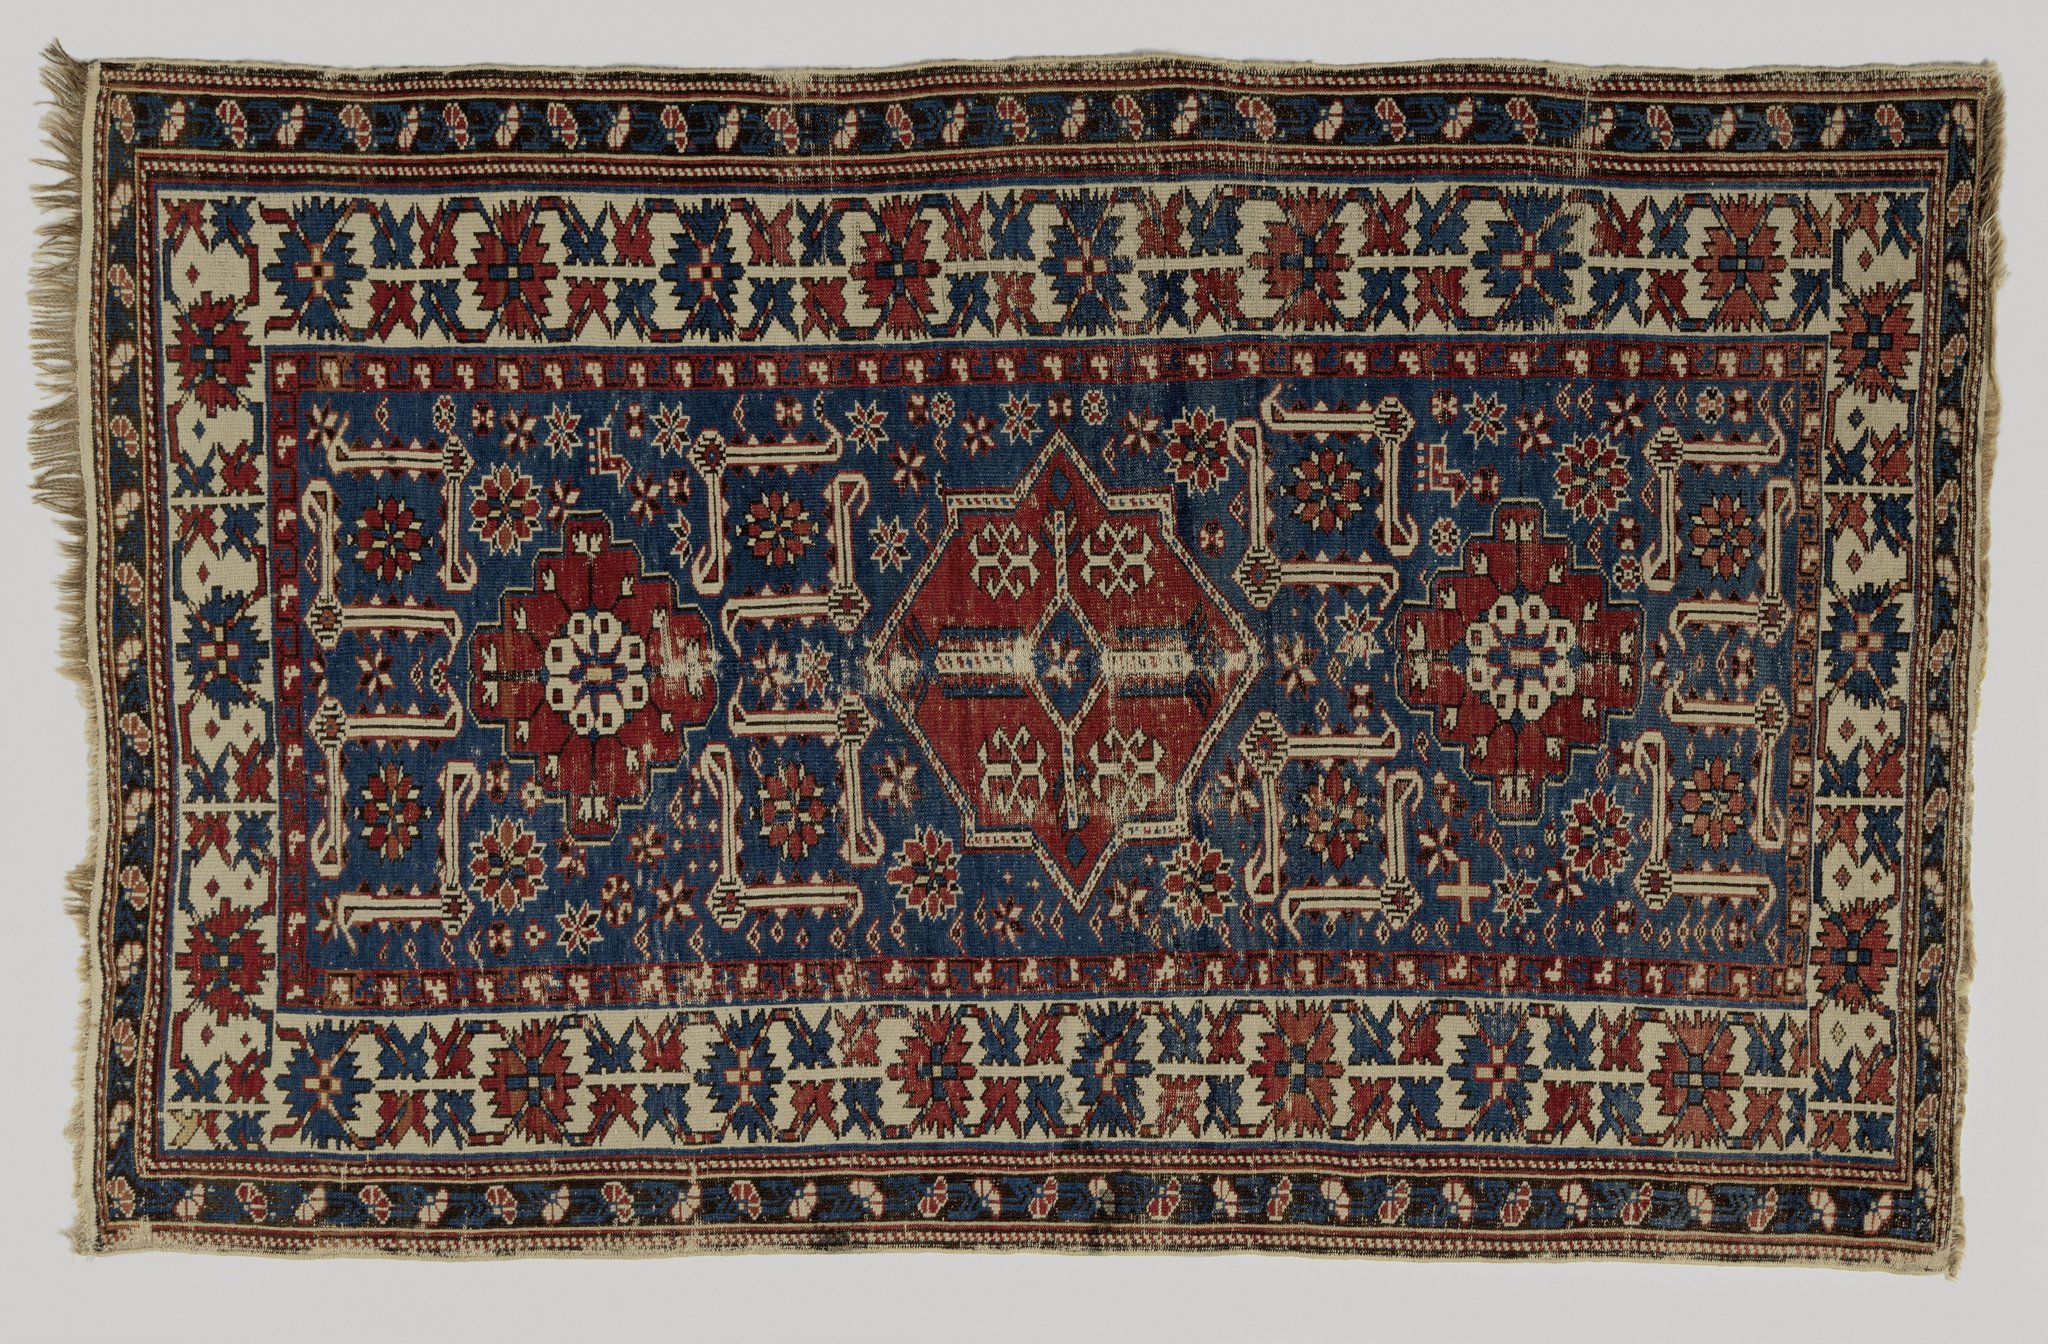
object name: oriental rug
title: Oosters tapijt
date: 1800-1900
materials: wool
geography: caucasus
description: Oosters tapijt, medaillonkleed, waarvan het middenveld versierd is met drie medaillons op een blauw fond. In de tussenruimte rozetten en arabesken en kleinere dier-, ster- en kruismotieven. De middelste rand is versierd met sterrozetten.